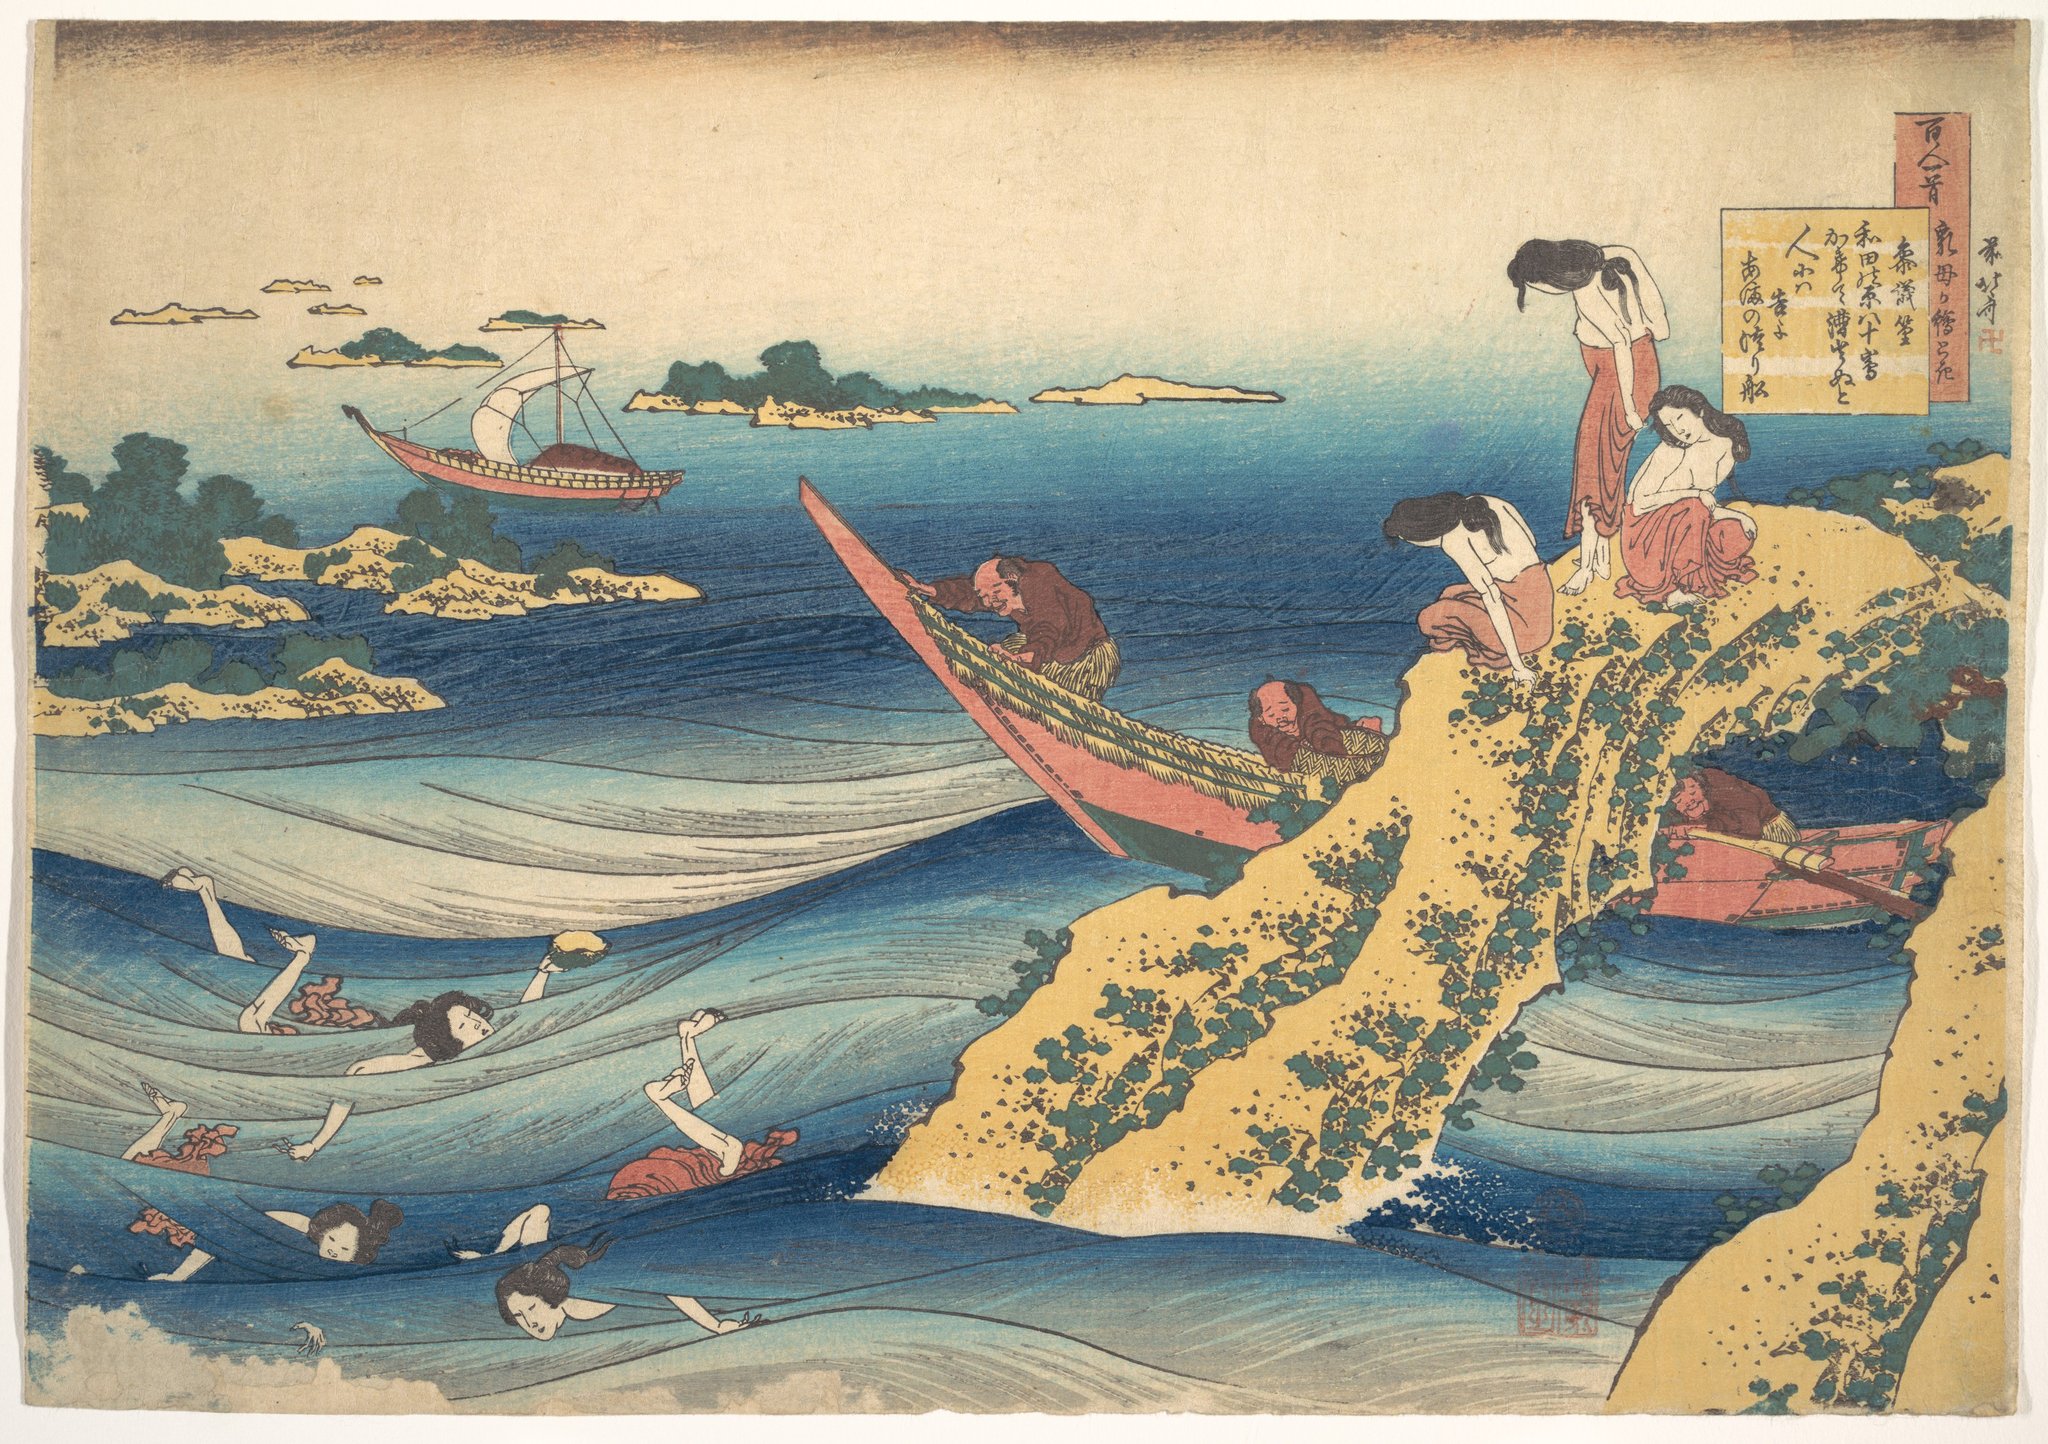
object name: woodblock print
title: Poem by Sangi no Takamura (Ono no Takamura), from the series One Hundred Poems Explained by the Nurse (Hyakunin isshu uba ga etoki)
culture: japanese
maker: katsushika hokusai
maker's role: artist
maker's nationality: japanese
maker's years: 1760-1849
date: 1835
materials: ink, paper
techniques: woodblock print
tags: men,women,swimming,waves,boats